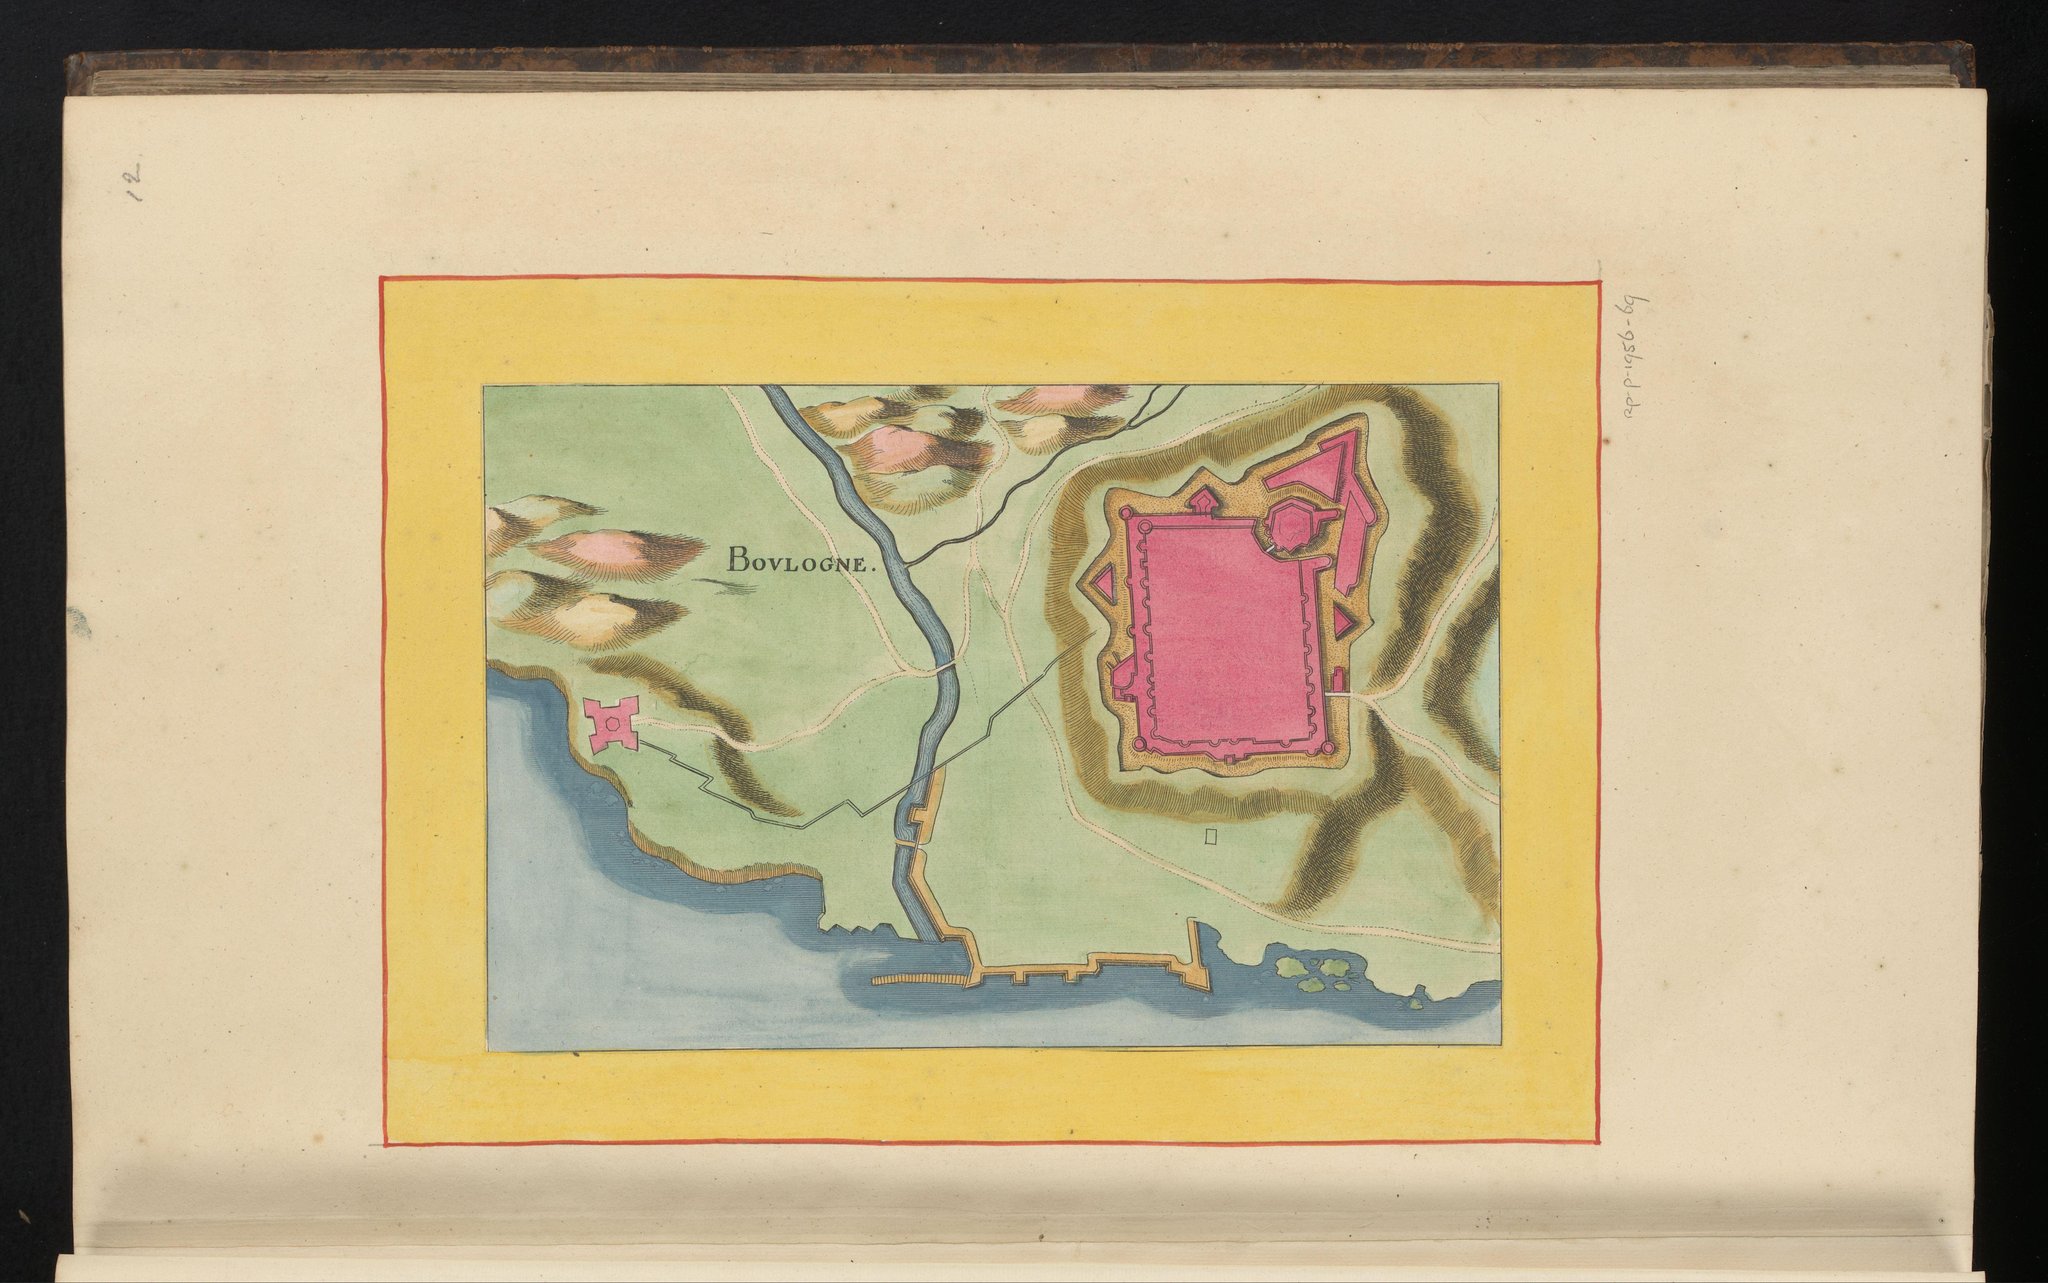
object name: area plan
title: Vestingplattegrond van Boulogne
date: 1656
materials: paper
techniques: engraving, etching, hand coloring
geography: the hague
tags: maps of cities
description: Kaart uit: Zeiller, Martin. Topographia Galliae. 13 dln. Frankfurt am Main: Caspar Merian, 1656, dl. 2, na p. 16.